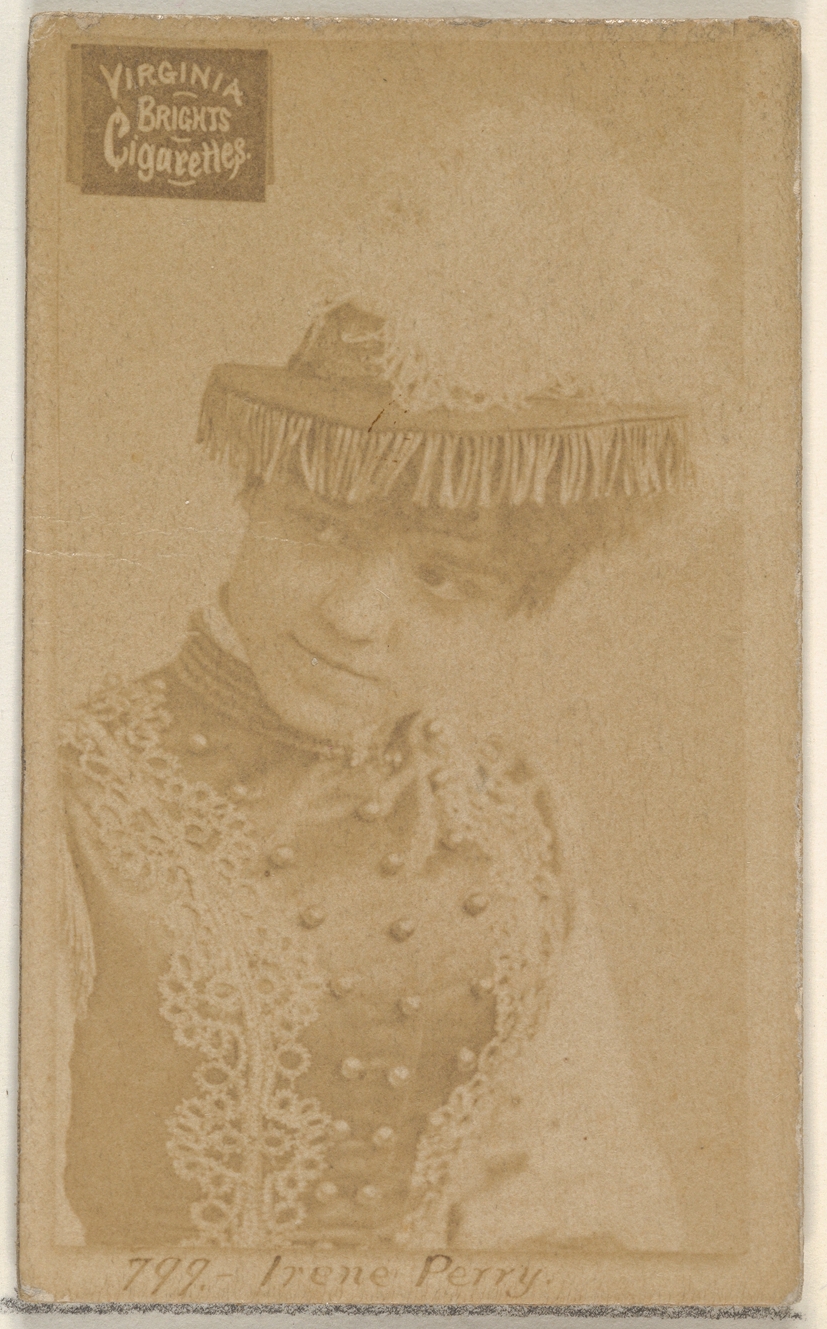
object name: photograph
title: Card 799, Irene Perry, from the Actors and Actresses series (N45, Type 2) for Virginia Brights Cigarettes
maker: allen & ginter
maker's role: publisher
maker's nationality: american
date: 1888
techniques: albumen silver print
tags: portraits,women,actresses